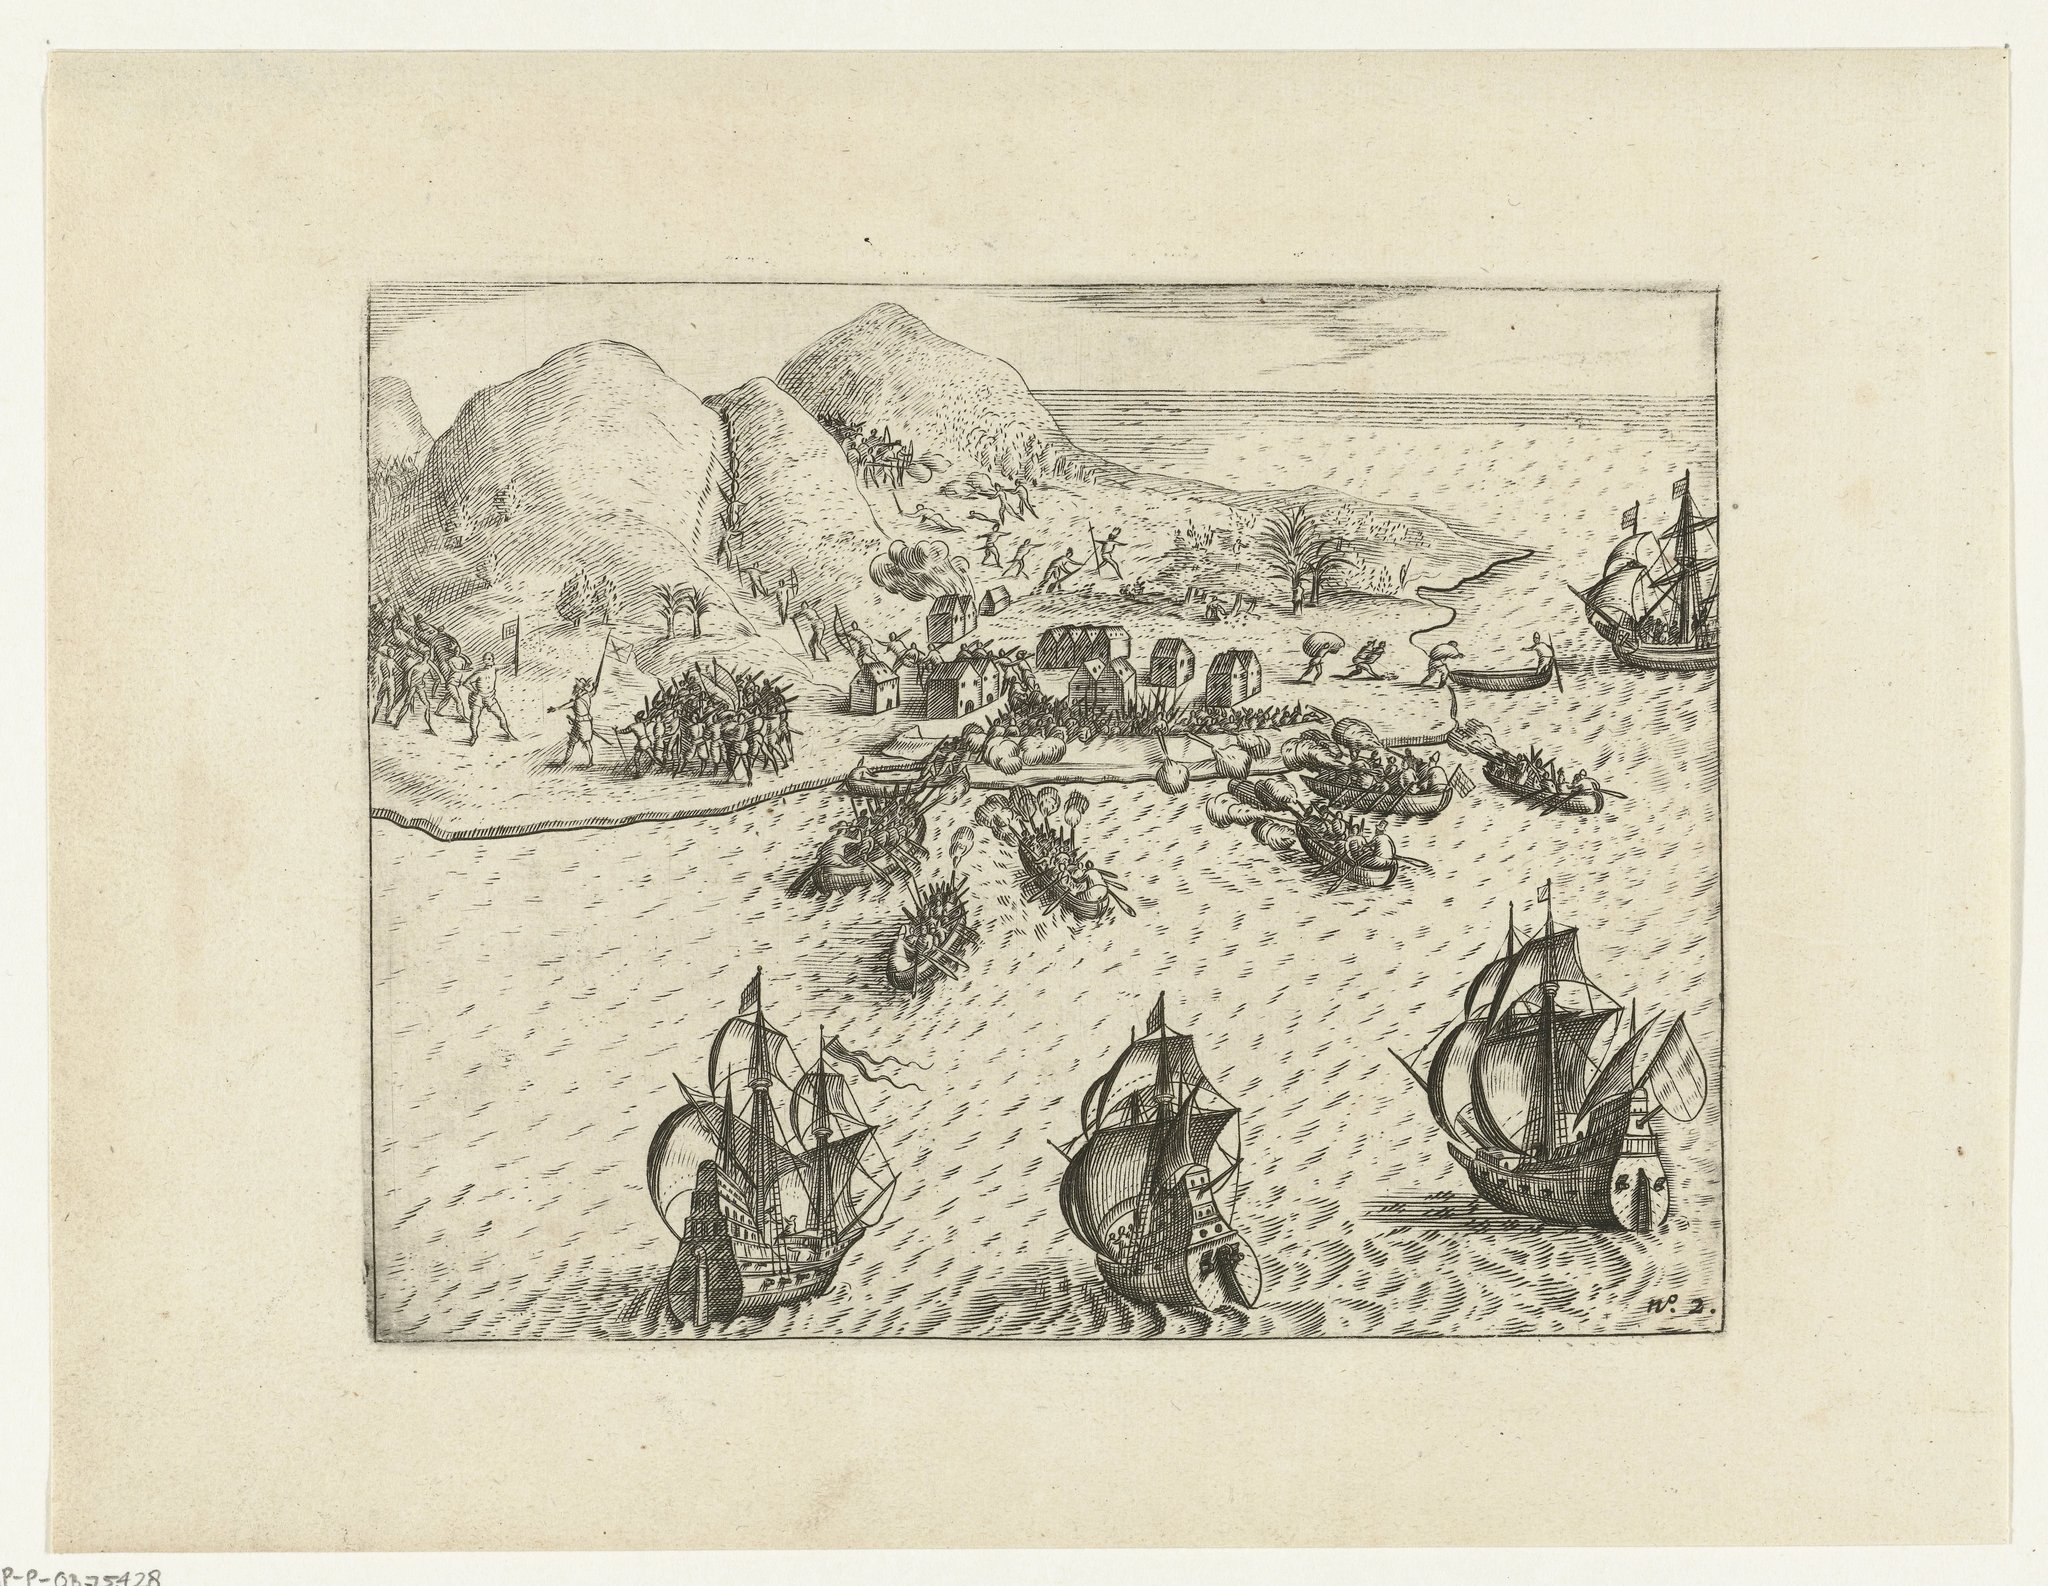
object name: print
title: Afteeckeninghe hoe het Eylandt Anabon, by de Hollanderen wert inghenomen ende gheplondert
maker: Anonymous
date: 1644-1646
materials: paper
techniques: engraving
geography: northern netherlands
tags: amsterdam, landscapes in tropical and sub-tropical regions, exploration, expedition, voyage of discovery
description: Gebruikt als illustratie in: Historische verhael Vande Reyse gedaen inde Oost-Indien, met 15 Schepen voor Reeckeninghe vande vereenichde Gheoctroyeerde Oost-Indische Compagnie. Deze tekst opgenomen in : I. Commelin, Begin ende voortgangh, van de Vereenighde Nederlantsche Geoctroyeerde Oost-Indische Compagnie, J. Janssonius, Amsterdam 1646. Genummerd: 2.